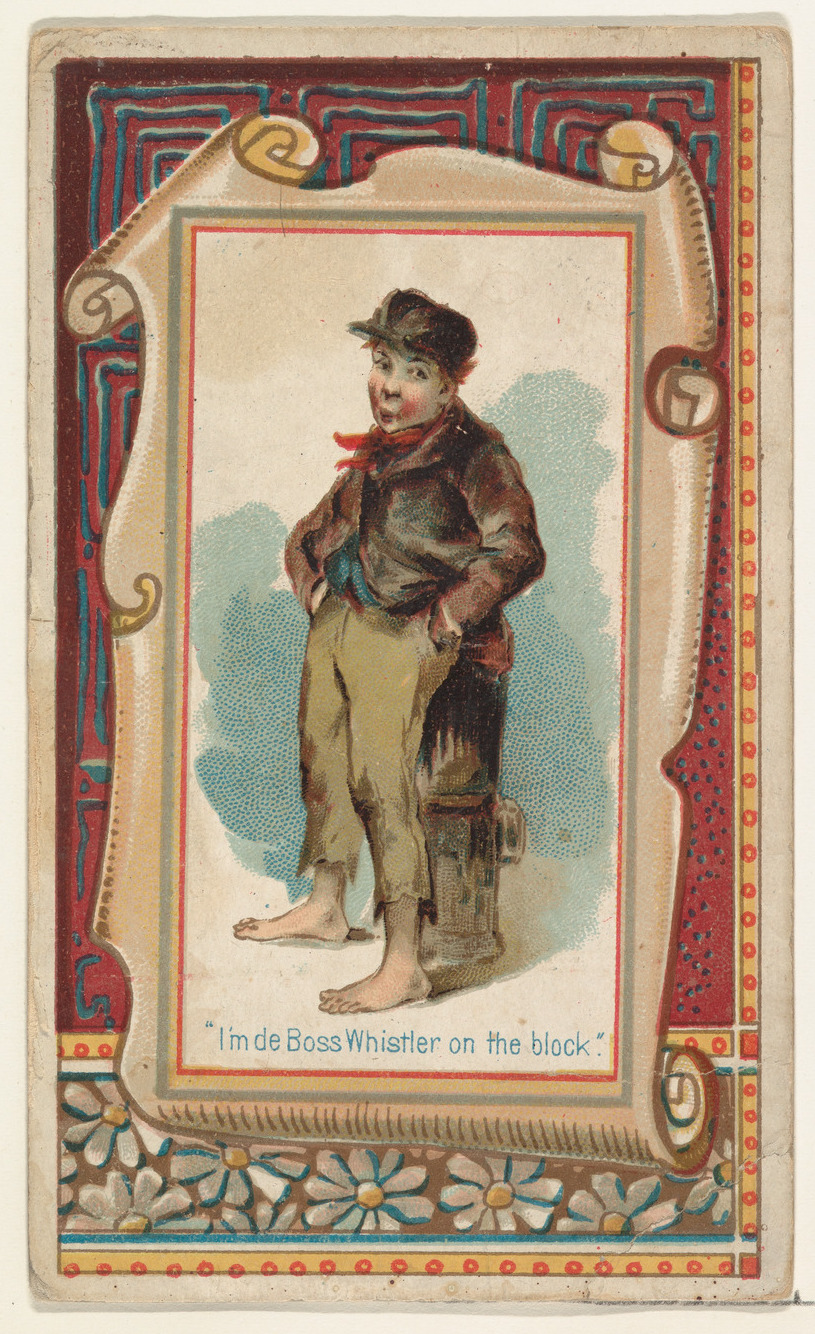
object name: print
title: "I'm de Boss Whistler on the block," from the Terrors of America set (N136) issued by Duke Sons & Co. to promote Honest Long Cut Tobacco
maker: w. duke, sons & co.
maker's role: publisher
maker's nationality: american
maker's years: 1870-1920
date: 1888-1889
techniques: color lithograph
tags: men